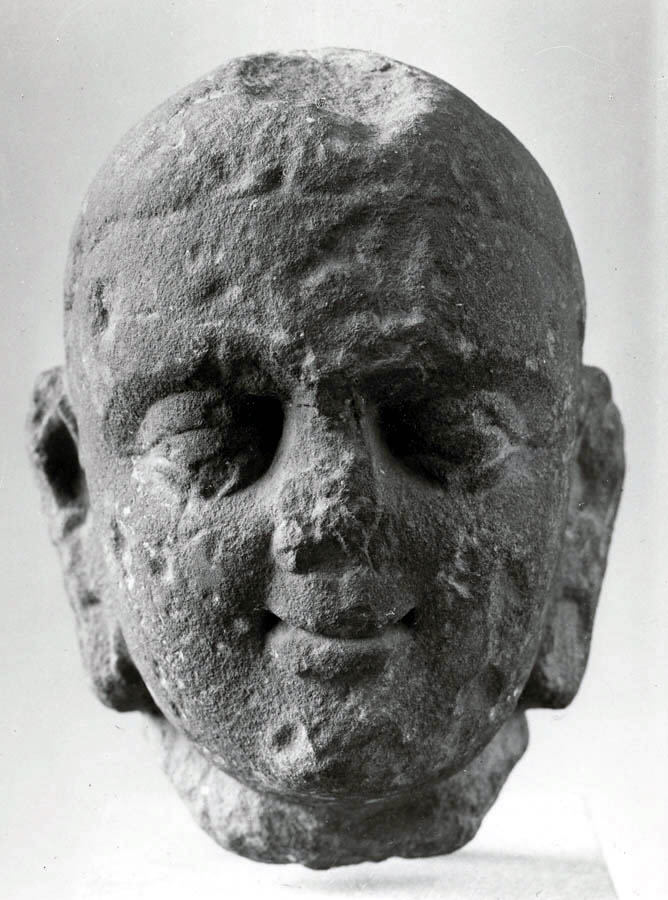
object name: head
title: Head of Buddha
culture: indian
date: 1-200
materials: stone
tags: kushan,mathura,heads,buddhism,buddha